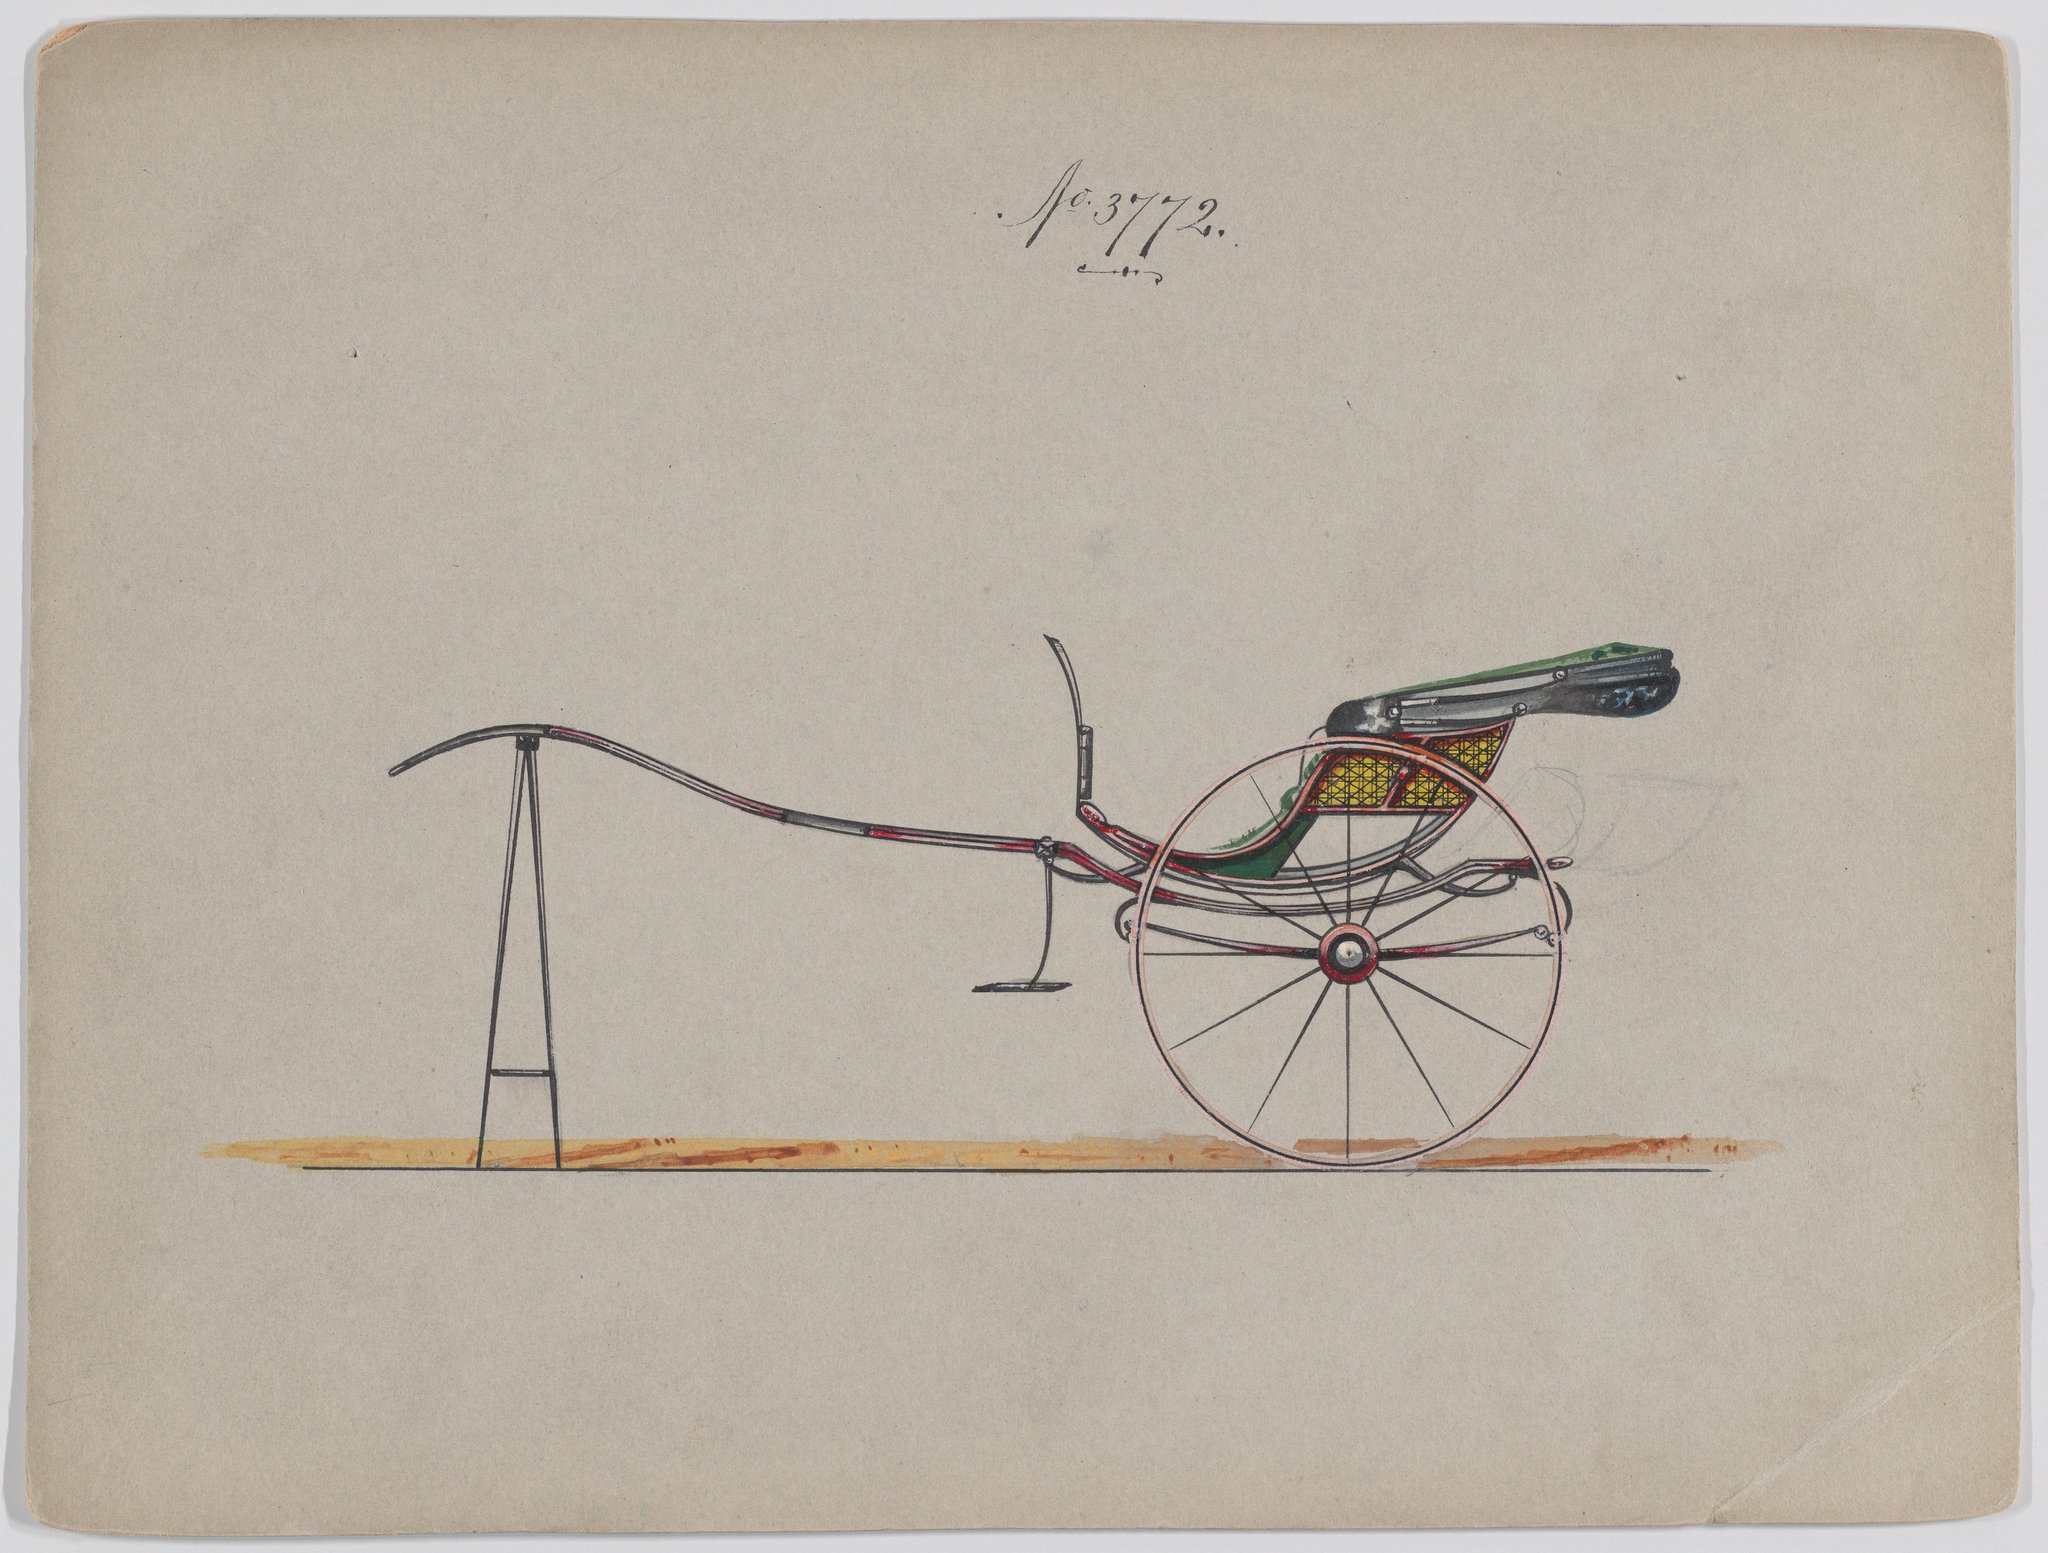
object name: drawing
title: Gig #3772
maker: brewster & co.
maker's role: manufacturer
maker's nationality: american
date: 1882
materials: gouache, gum arabic, ink, watercolor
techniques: pen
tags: carriages